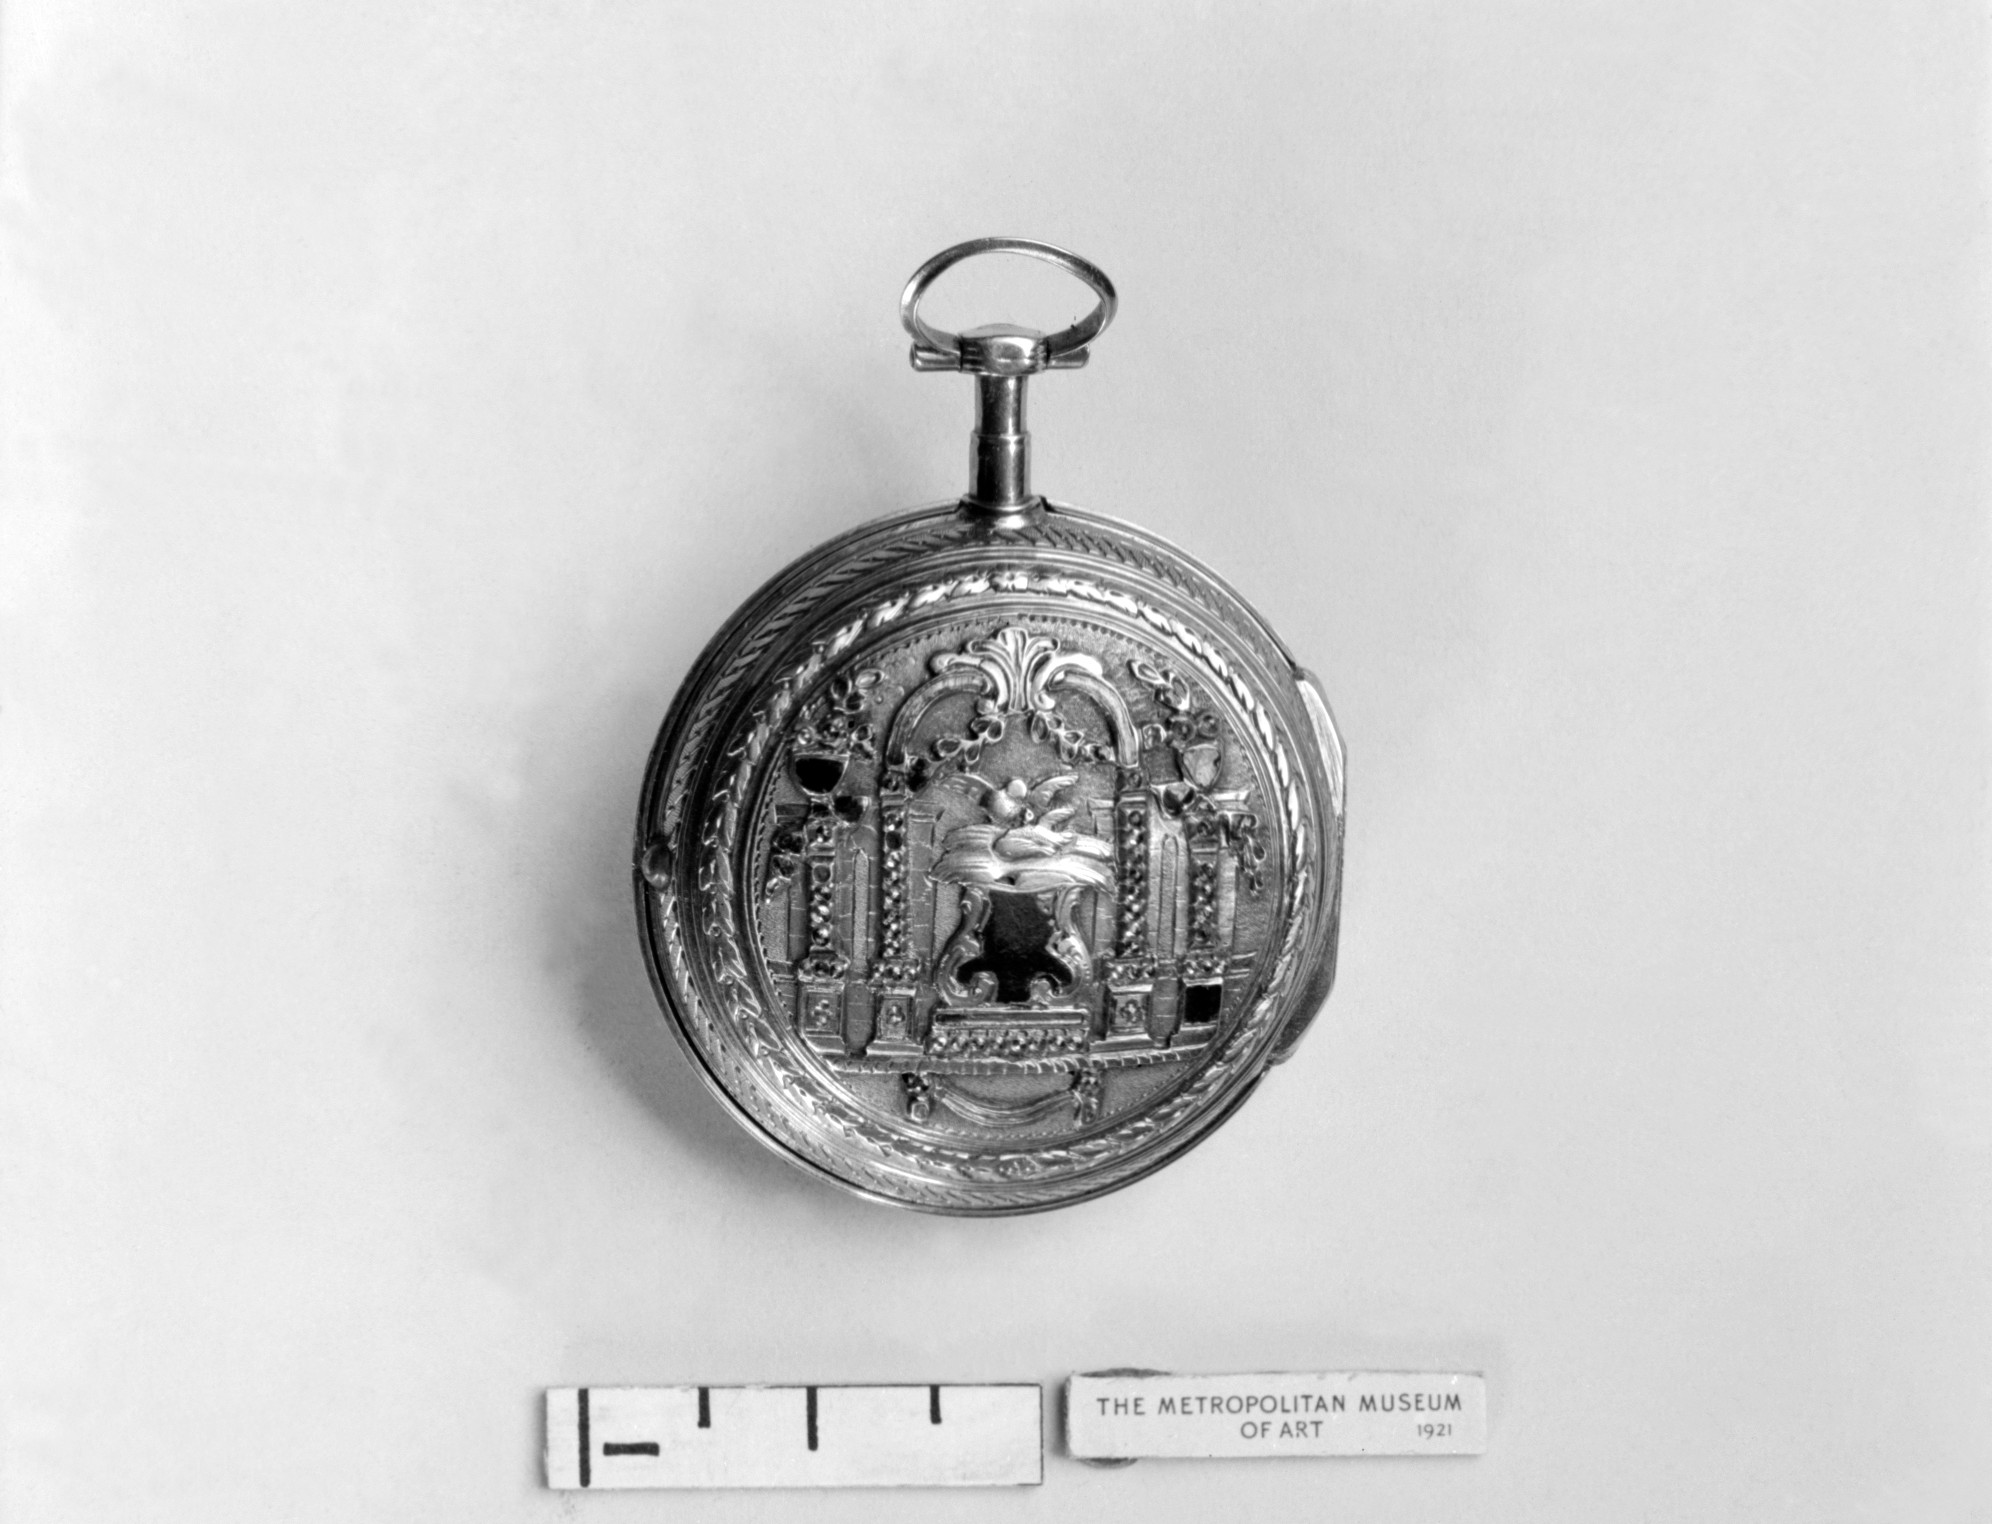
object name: watch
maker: ferdinand berthoud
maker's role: maker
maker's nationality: french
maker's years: 1727-1807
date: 1701-1800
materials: diamond, enamel, gold